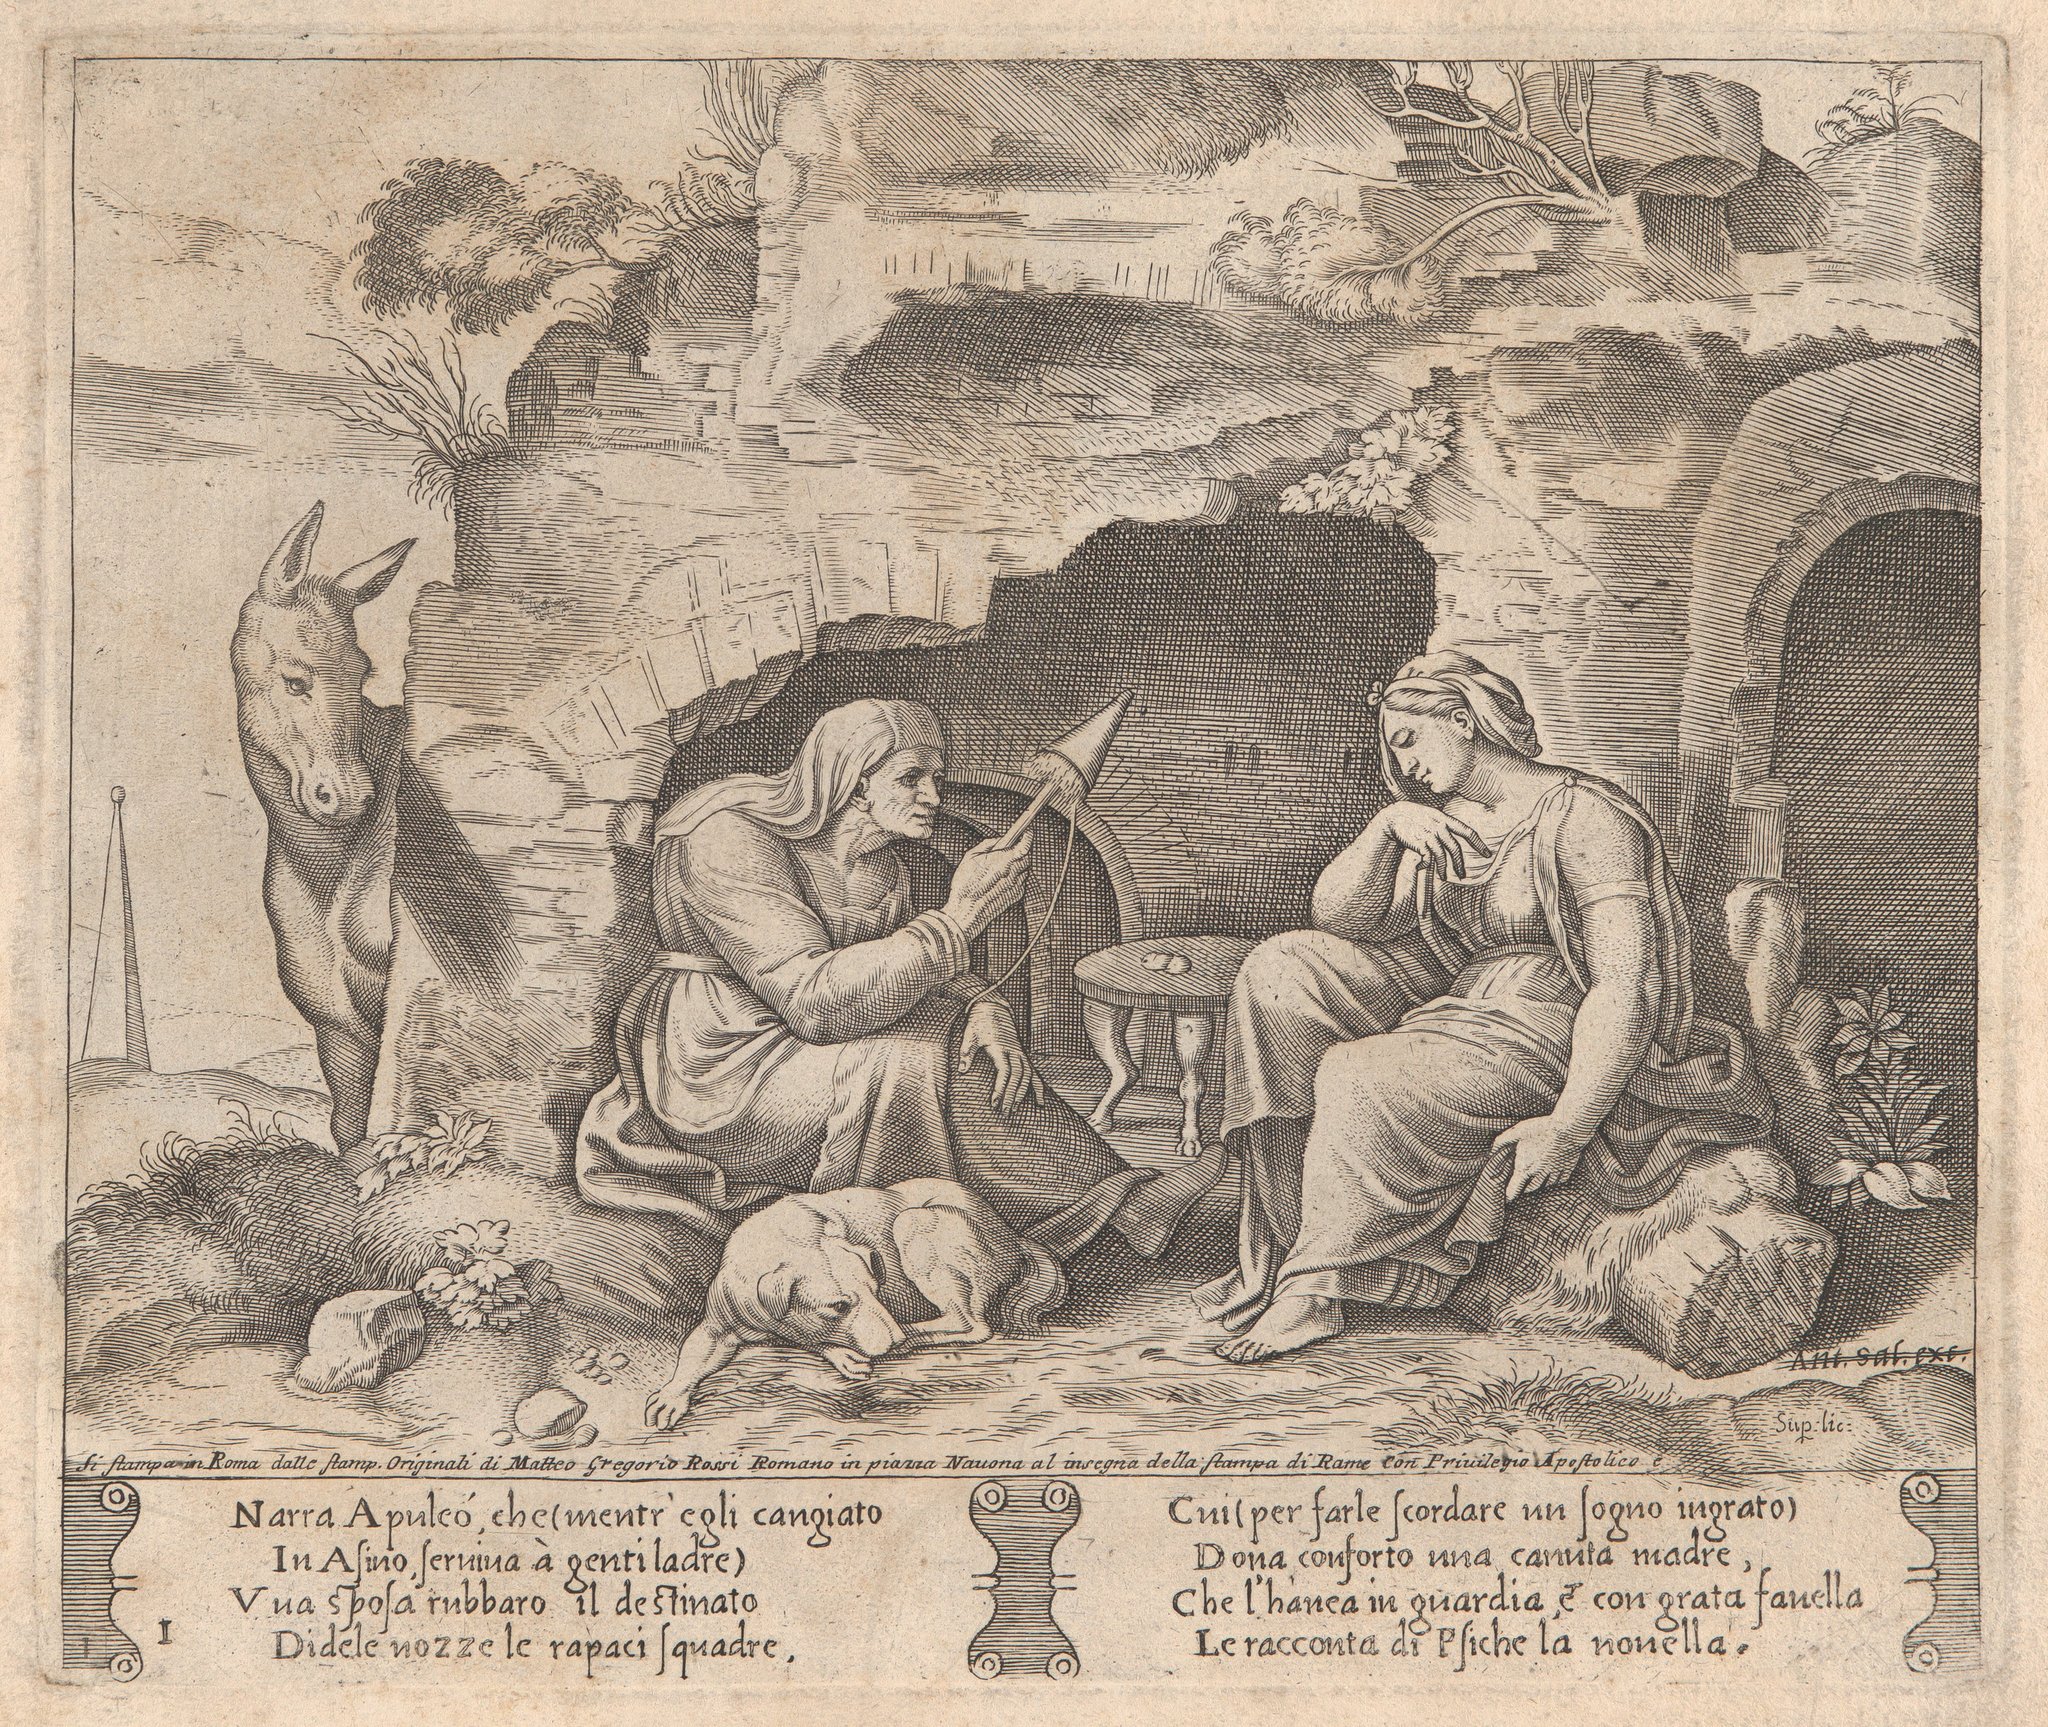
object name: print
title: Plate 1: Apuleius changed into a donkey, listening to the story told by the old woman, from "The Story of Cupid and Psyche as told by Apuleius"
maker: master of the die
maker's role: artist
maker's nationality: italian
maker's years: 1525-1560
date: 1530-1560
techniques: engraving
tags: women,psyche,donkeys